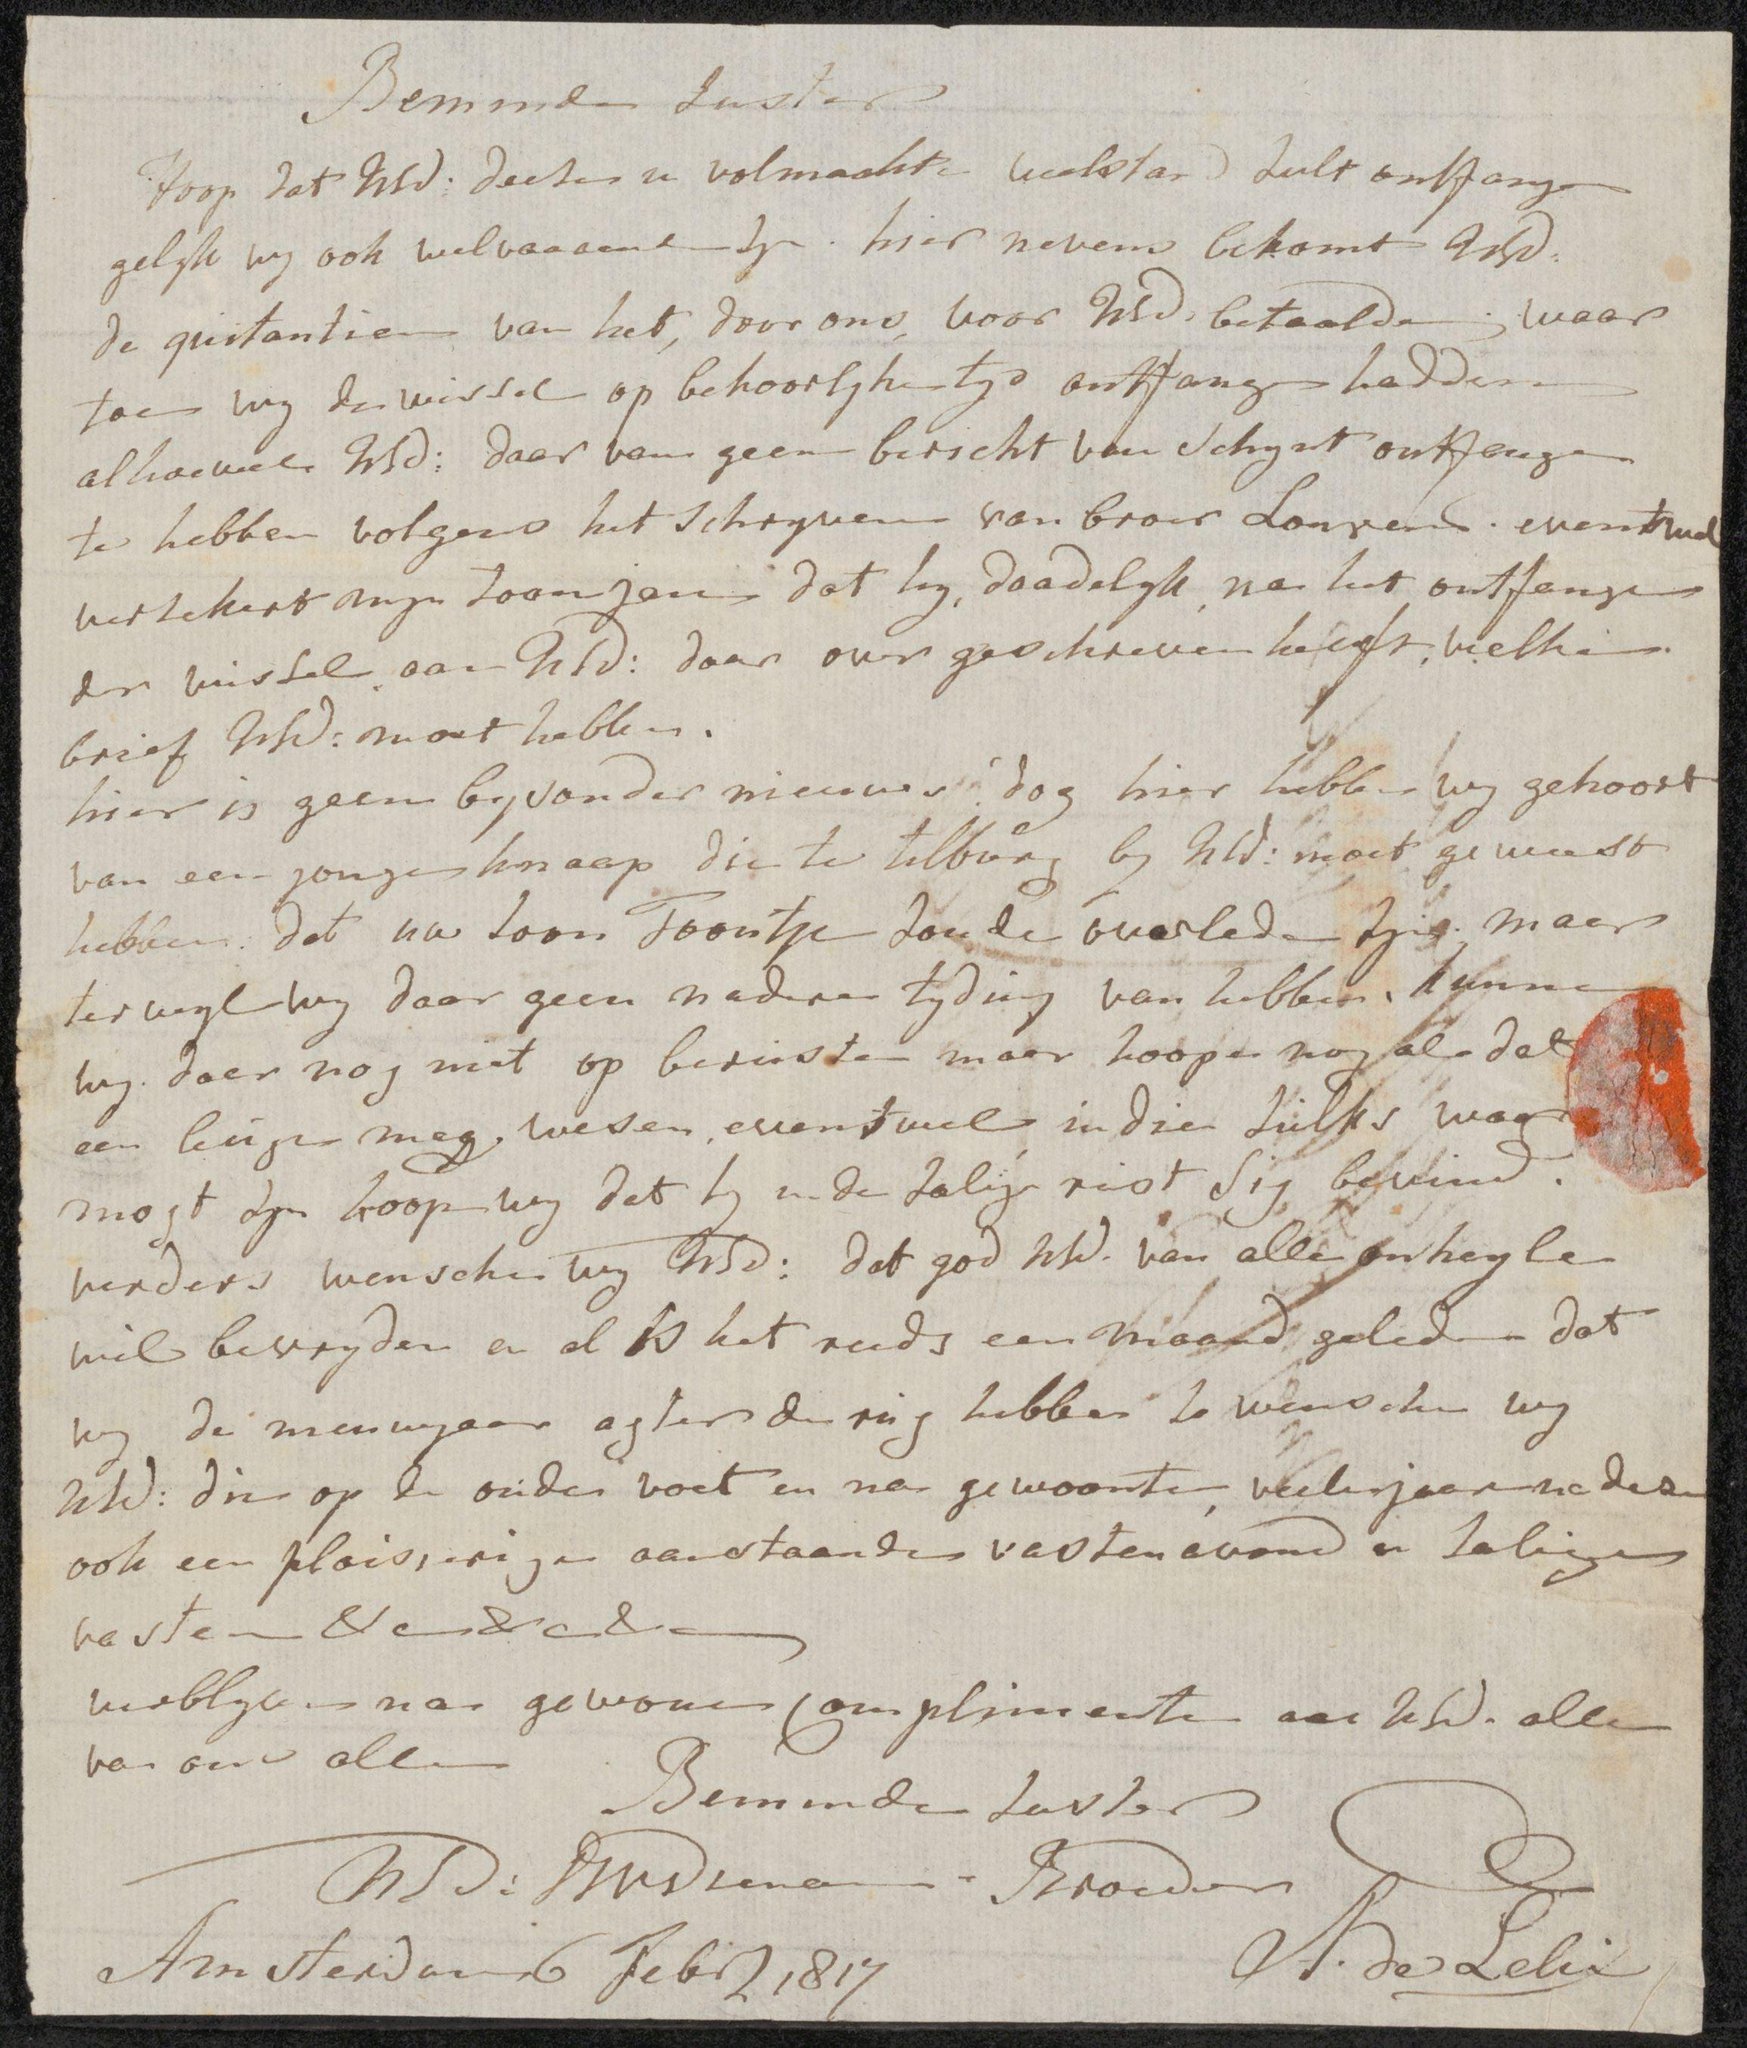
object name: letter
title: Brief aan onbekend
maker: adriaan de lelie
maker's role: draughtsman, painter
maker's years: 1755-1820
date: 1817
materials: ink, paper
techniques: pen, writing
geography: amsterdam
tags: family life, money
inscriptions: watermark